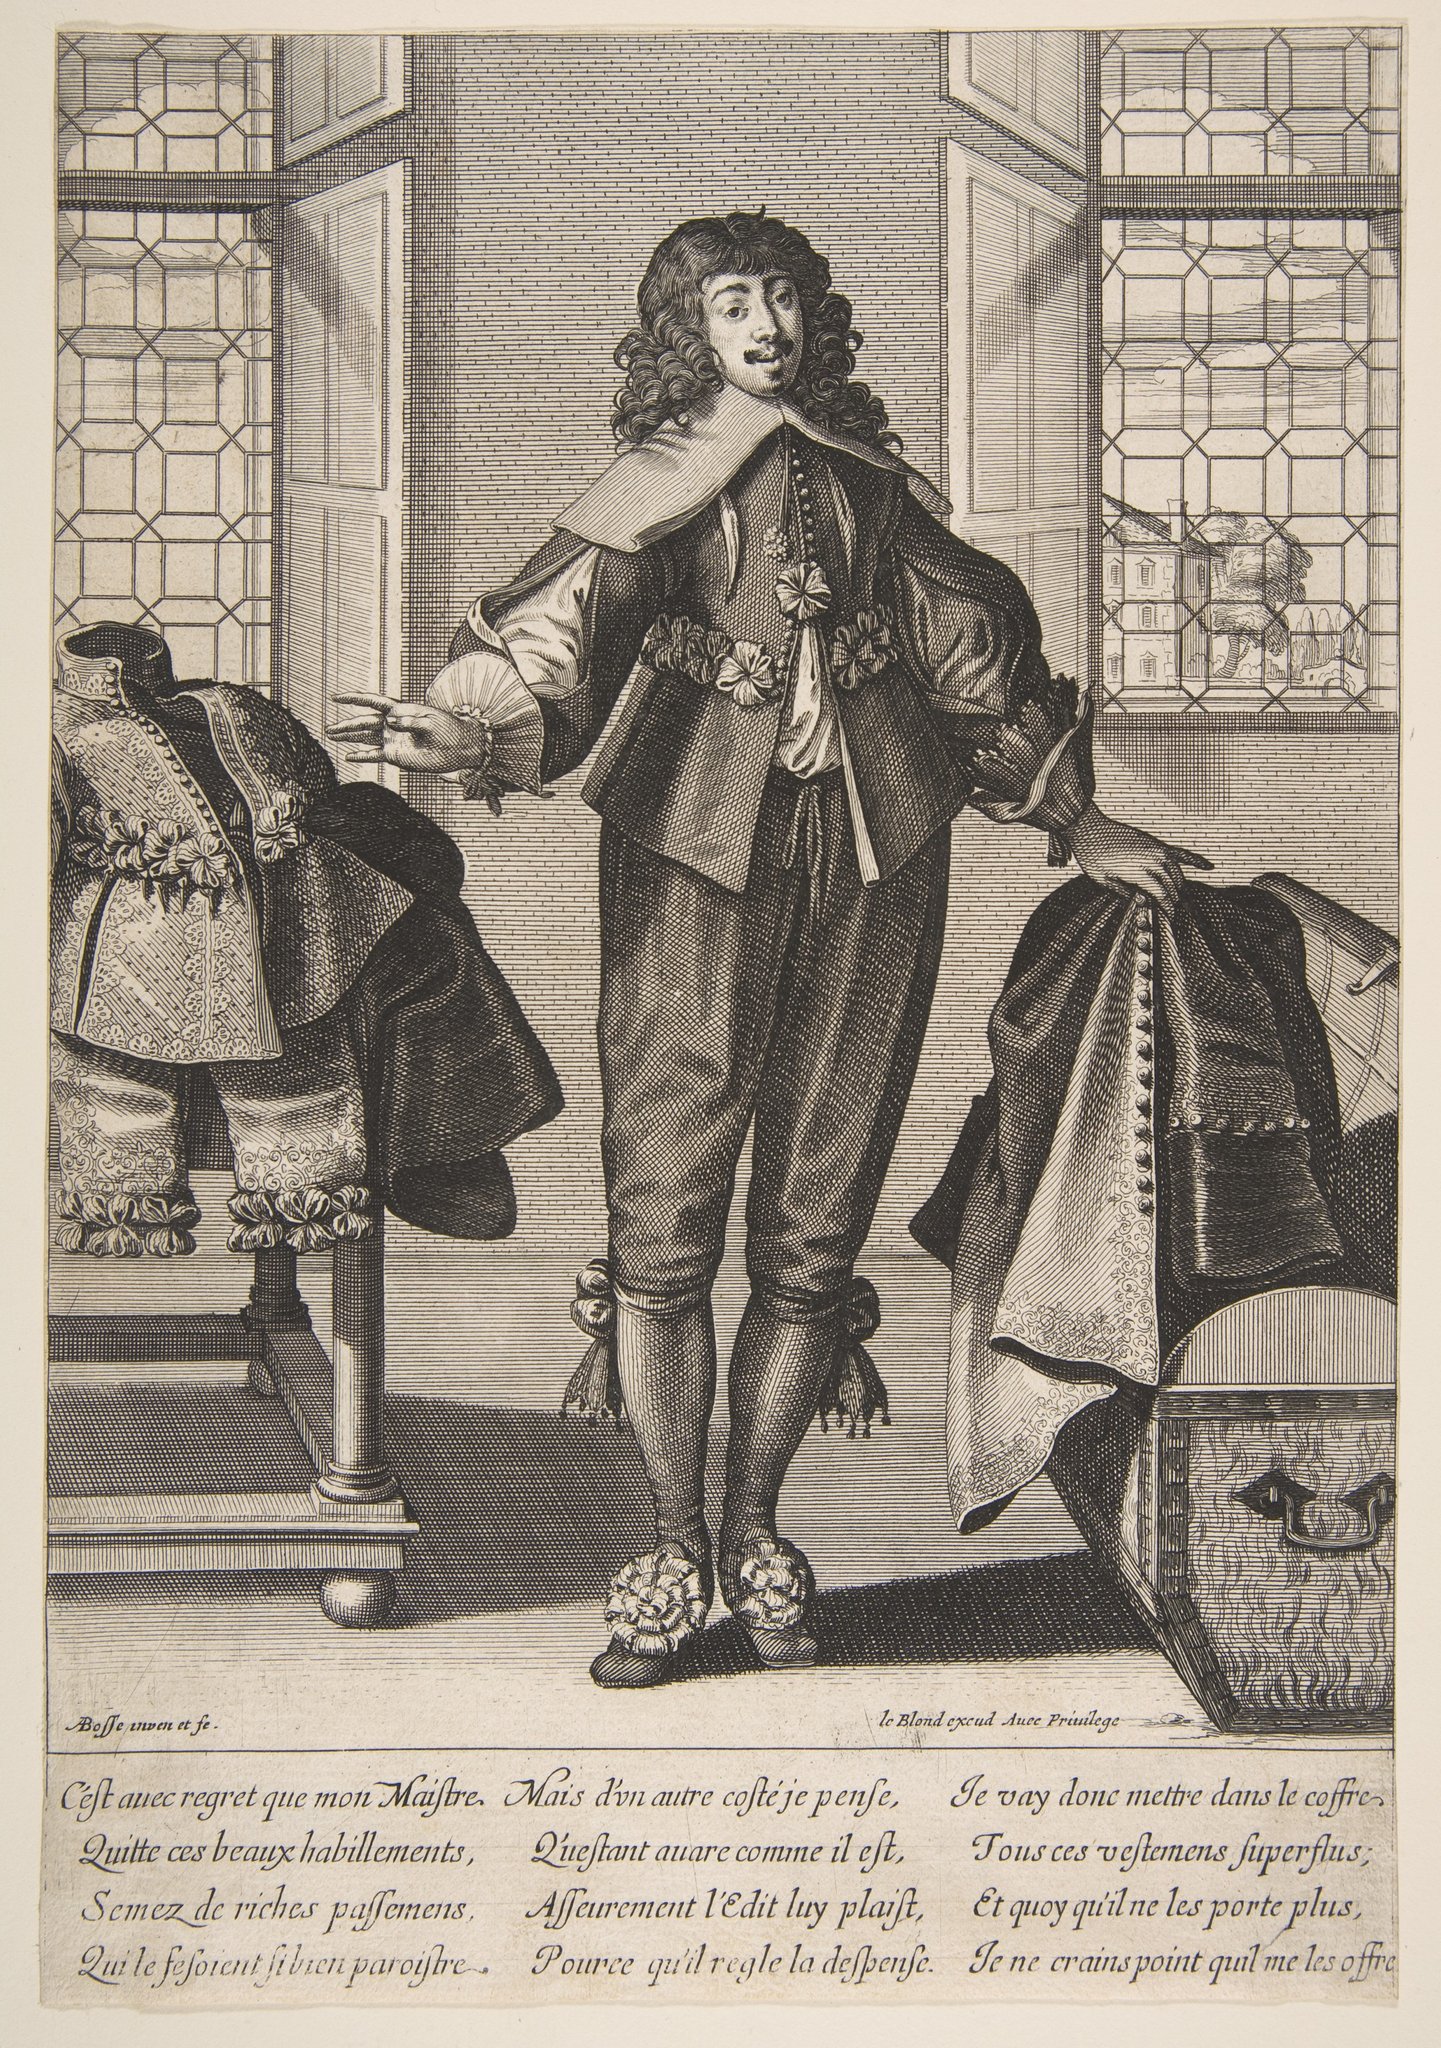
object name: print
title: A Valet Putting Away the Luxious Clothes of His Master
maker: abraham bosse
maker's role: artist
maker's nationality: french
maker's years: 1602-1676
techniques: etching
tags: men,portraits